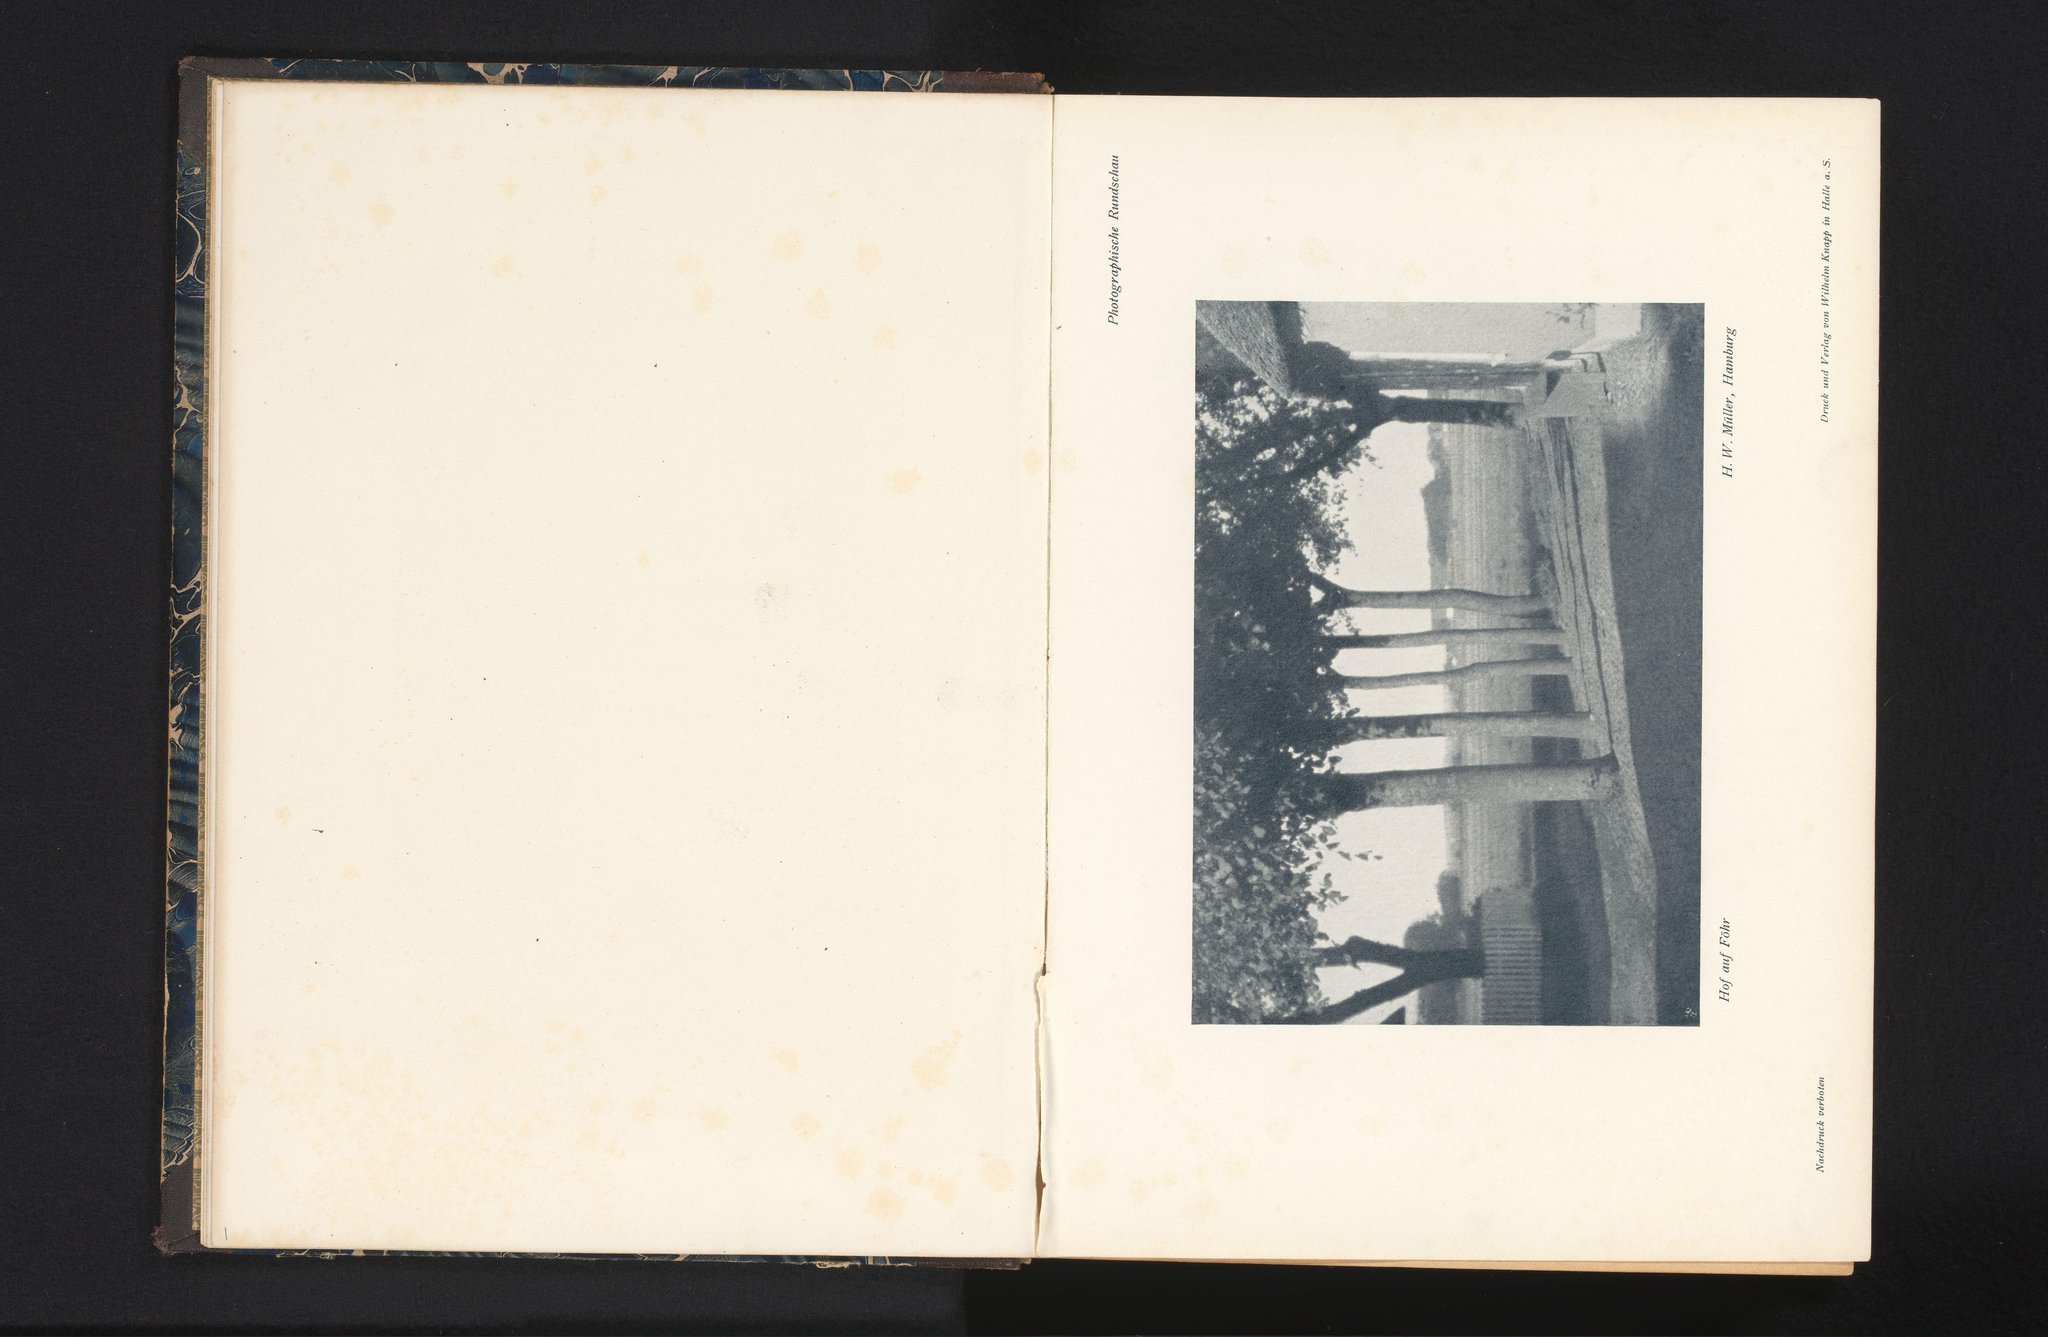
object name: page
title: Gezicht op een aantal bomen en een weiland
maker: h.w. müller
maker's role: fotograaf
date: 1897-1902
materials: paper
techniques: autotype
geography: halle an der saale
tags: trees, meadow, pasture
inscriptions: monogram: ‘MR&C’